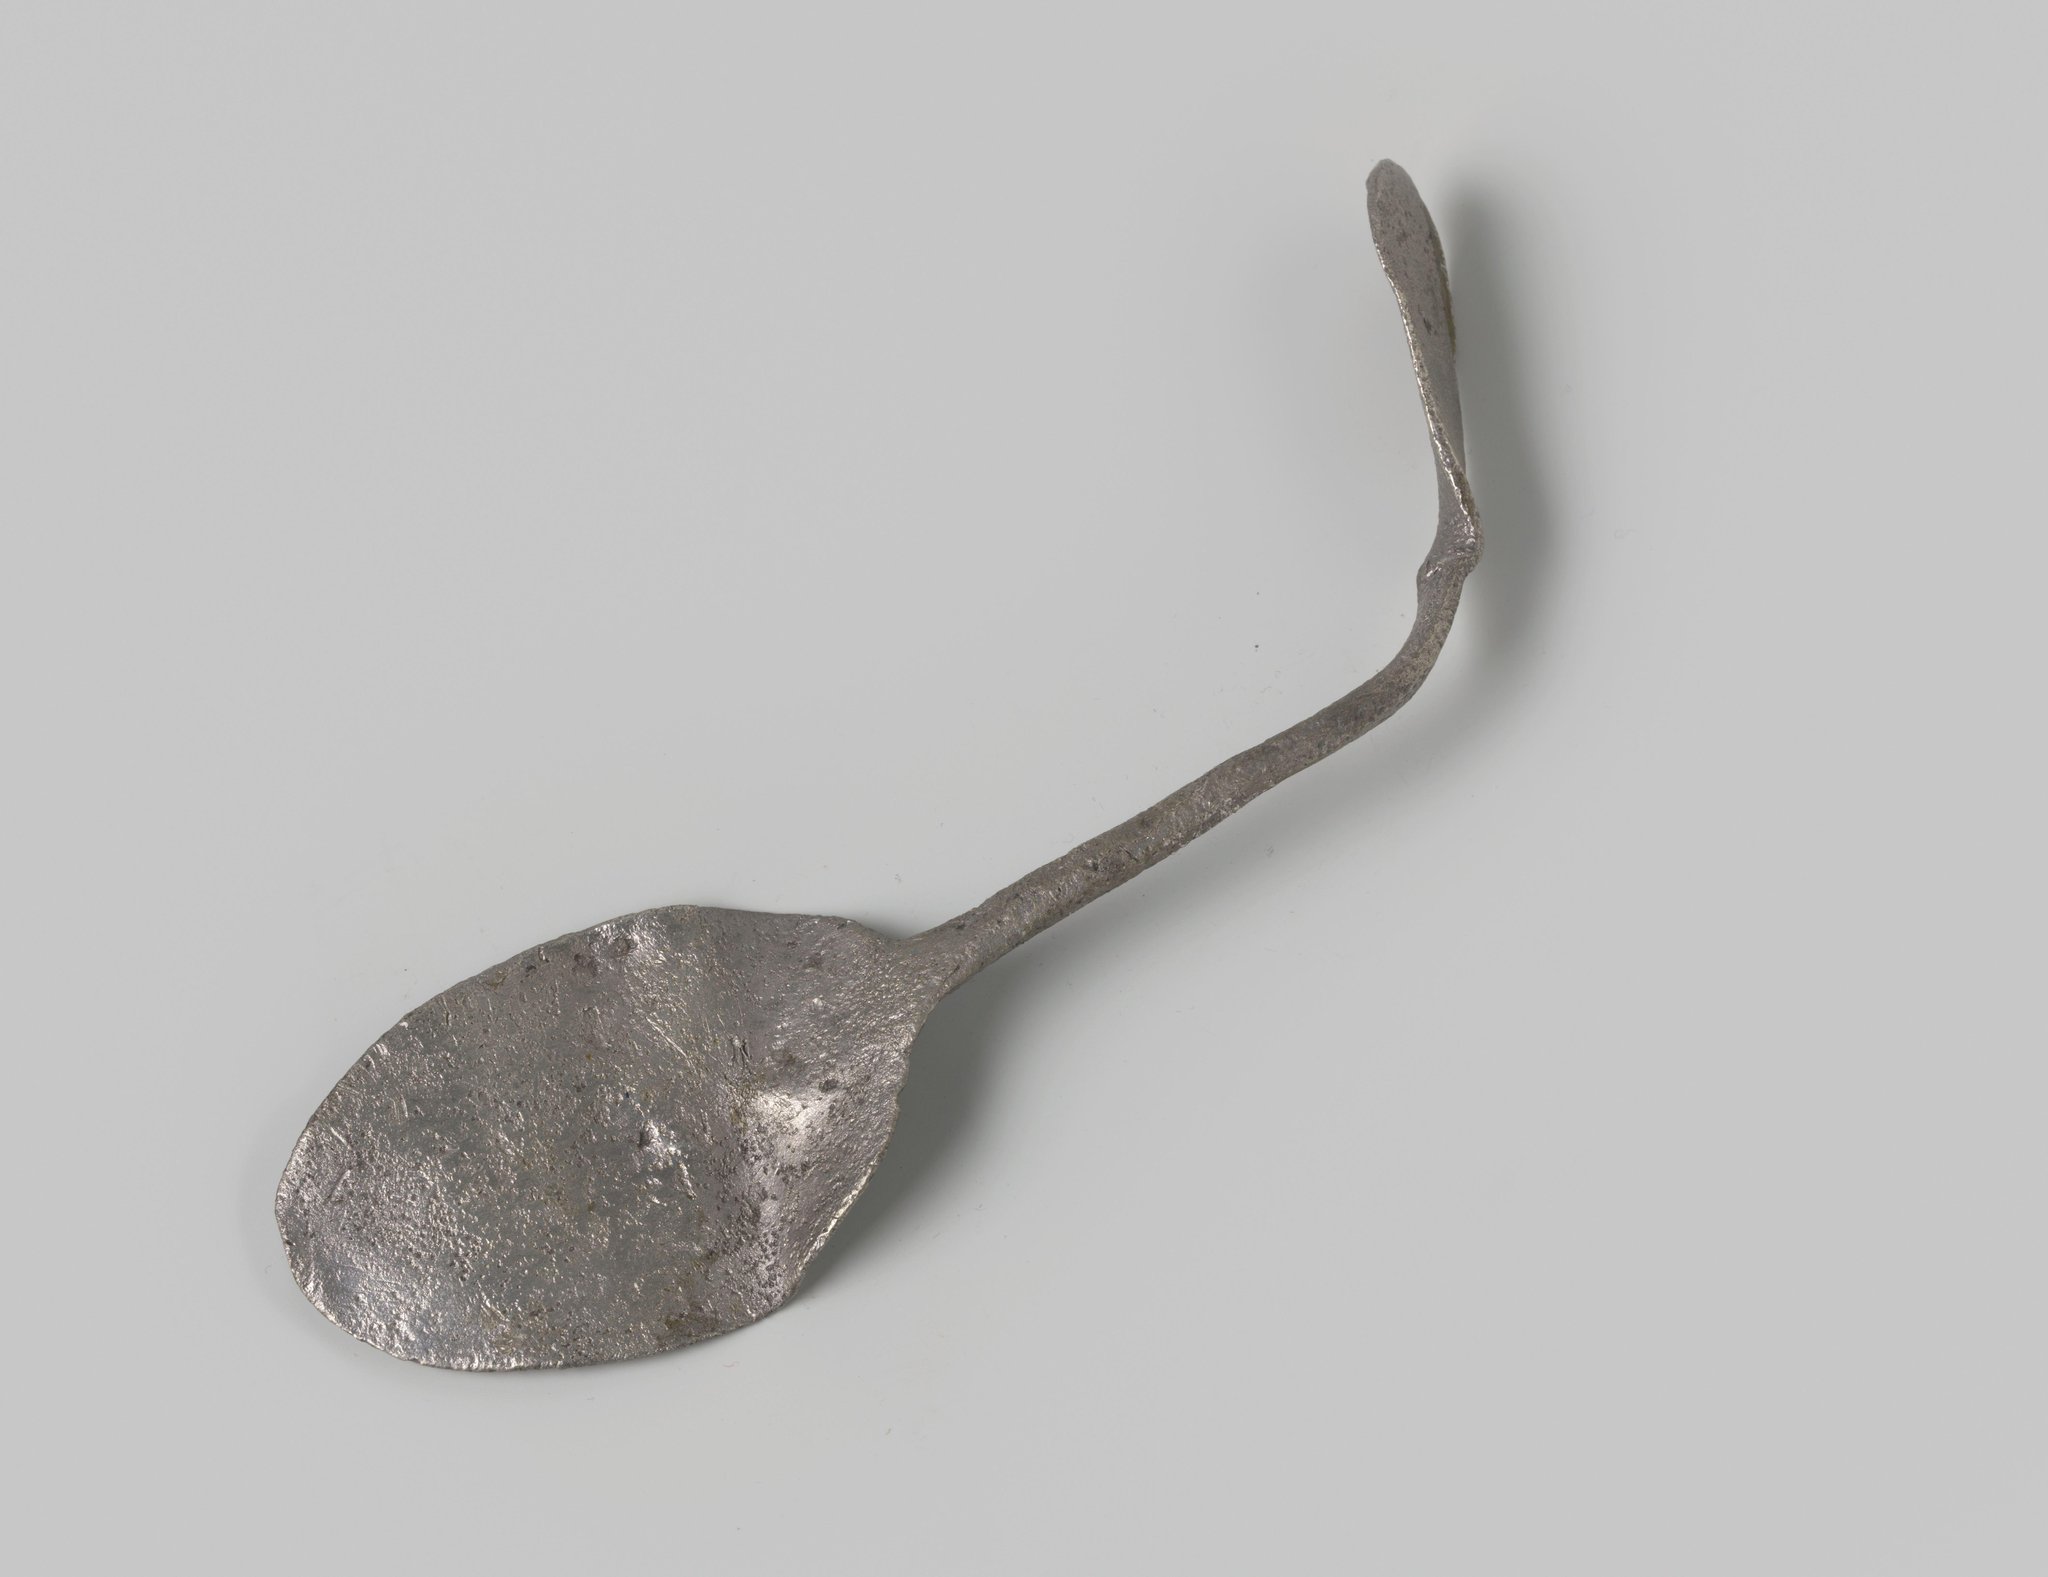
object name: spoon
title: Lepel uit het wrak van de Oost-Indiëvaarder Hollandia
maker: Anonymous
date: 1700-1743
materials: tin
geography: netherlands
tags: verenigde oostindische compagnie, hollandia (schip), annet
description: Cutlery, spoon; bent, corroded, bowl id. NG-1980-27-H-1165, stem id. NG-1980-27-H-527, no inscription visible.